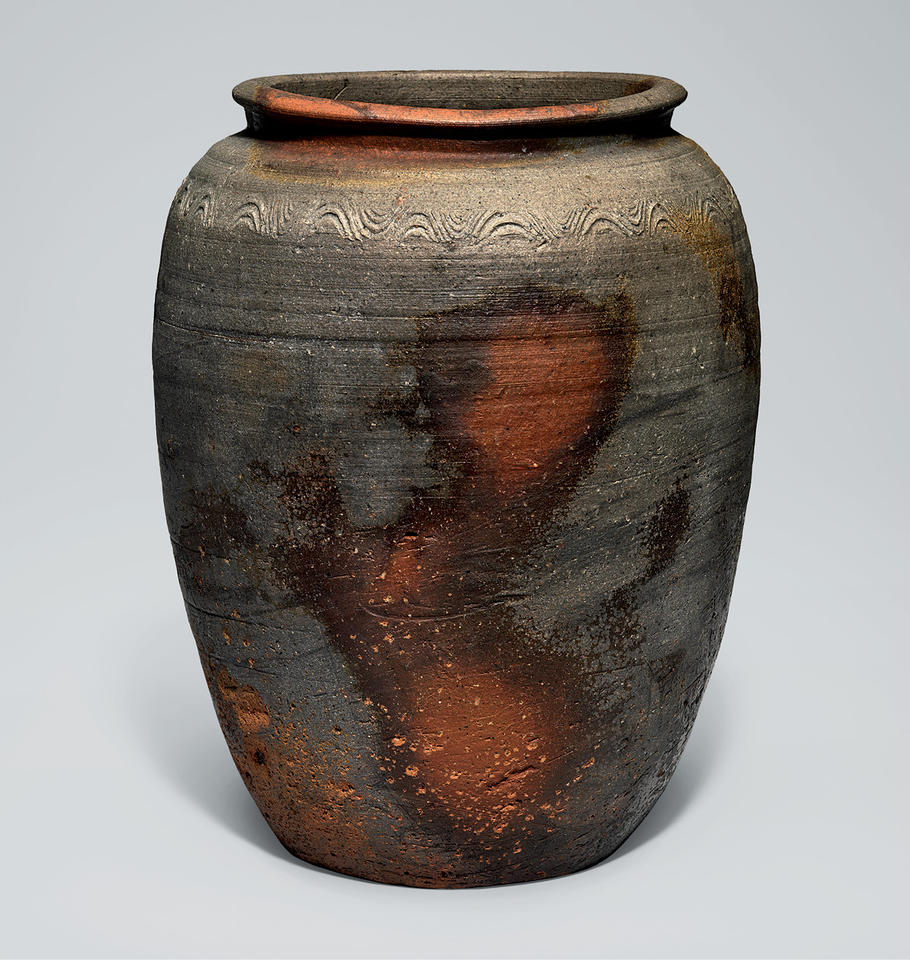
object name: jar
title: Widemouthed jar (kame) with wave pattern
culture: japanese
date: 1567-1633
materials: stoneware